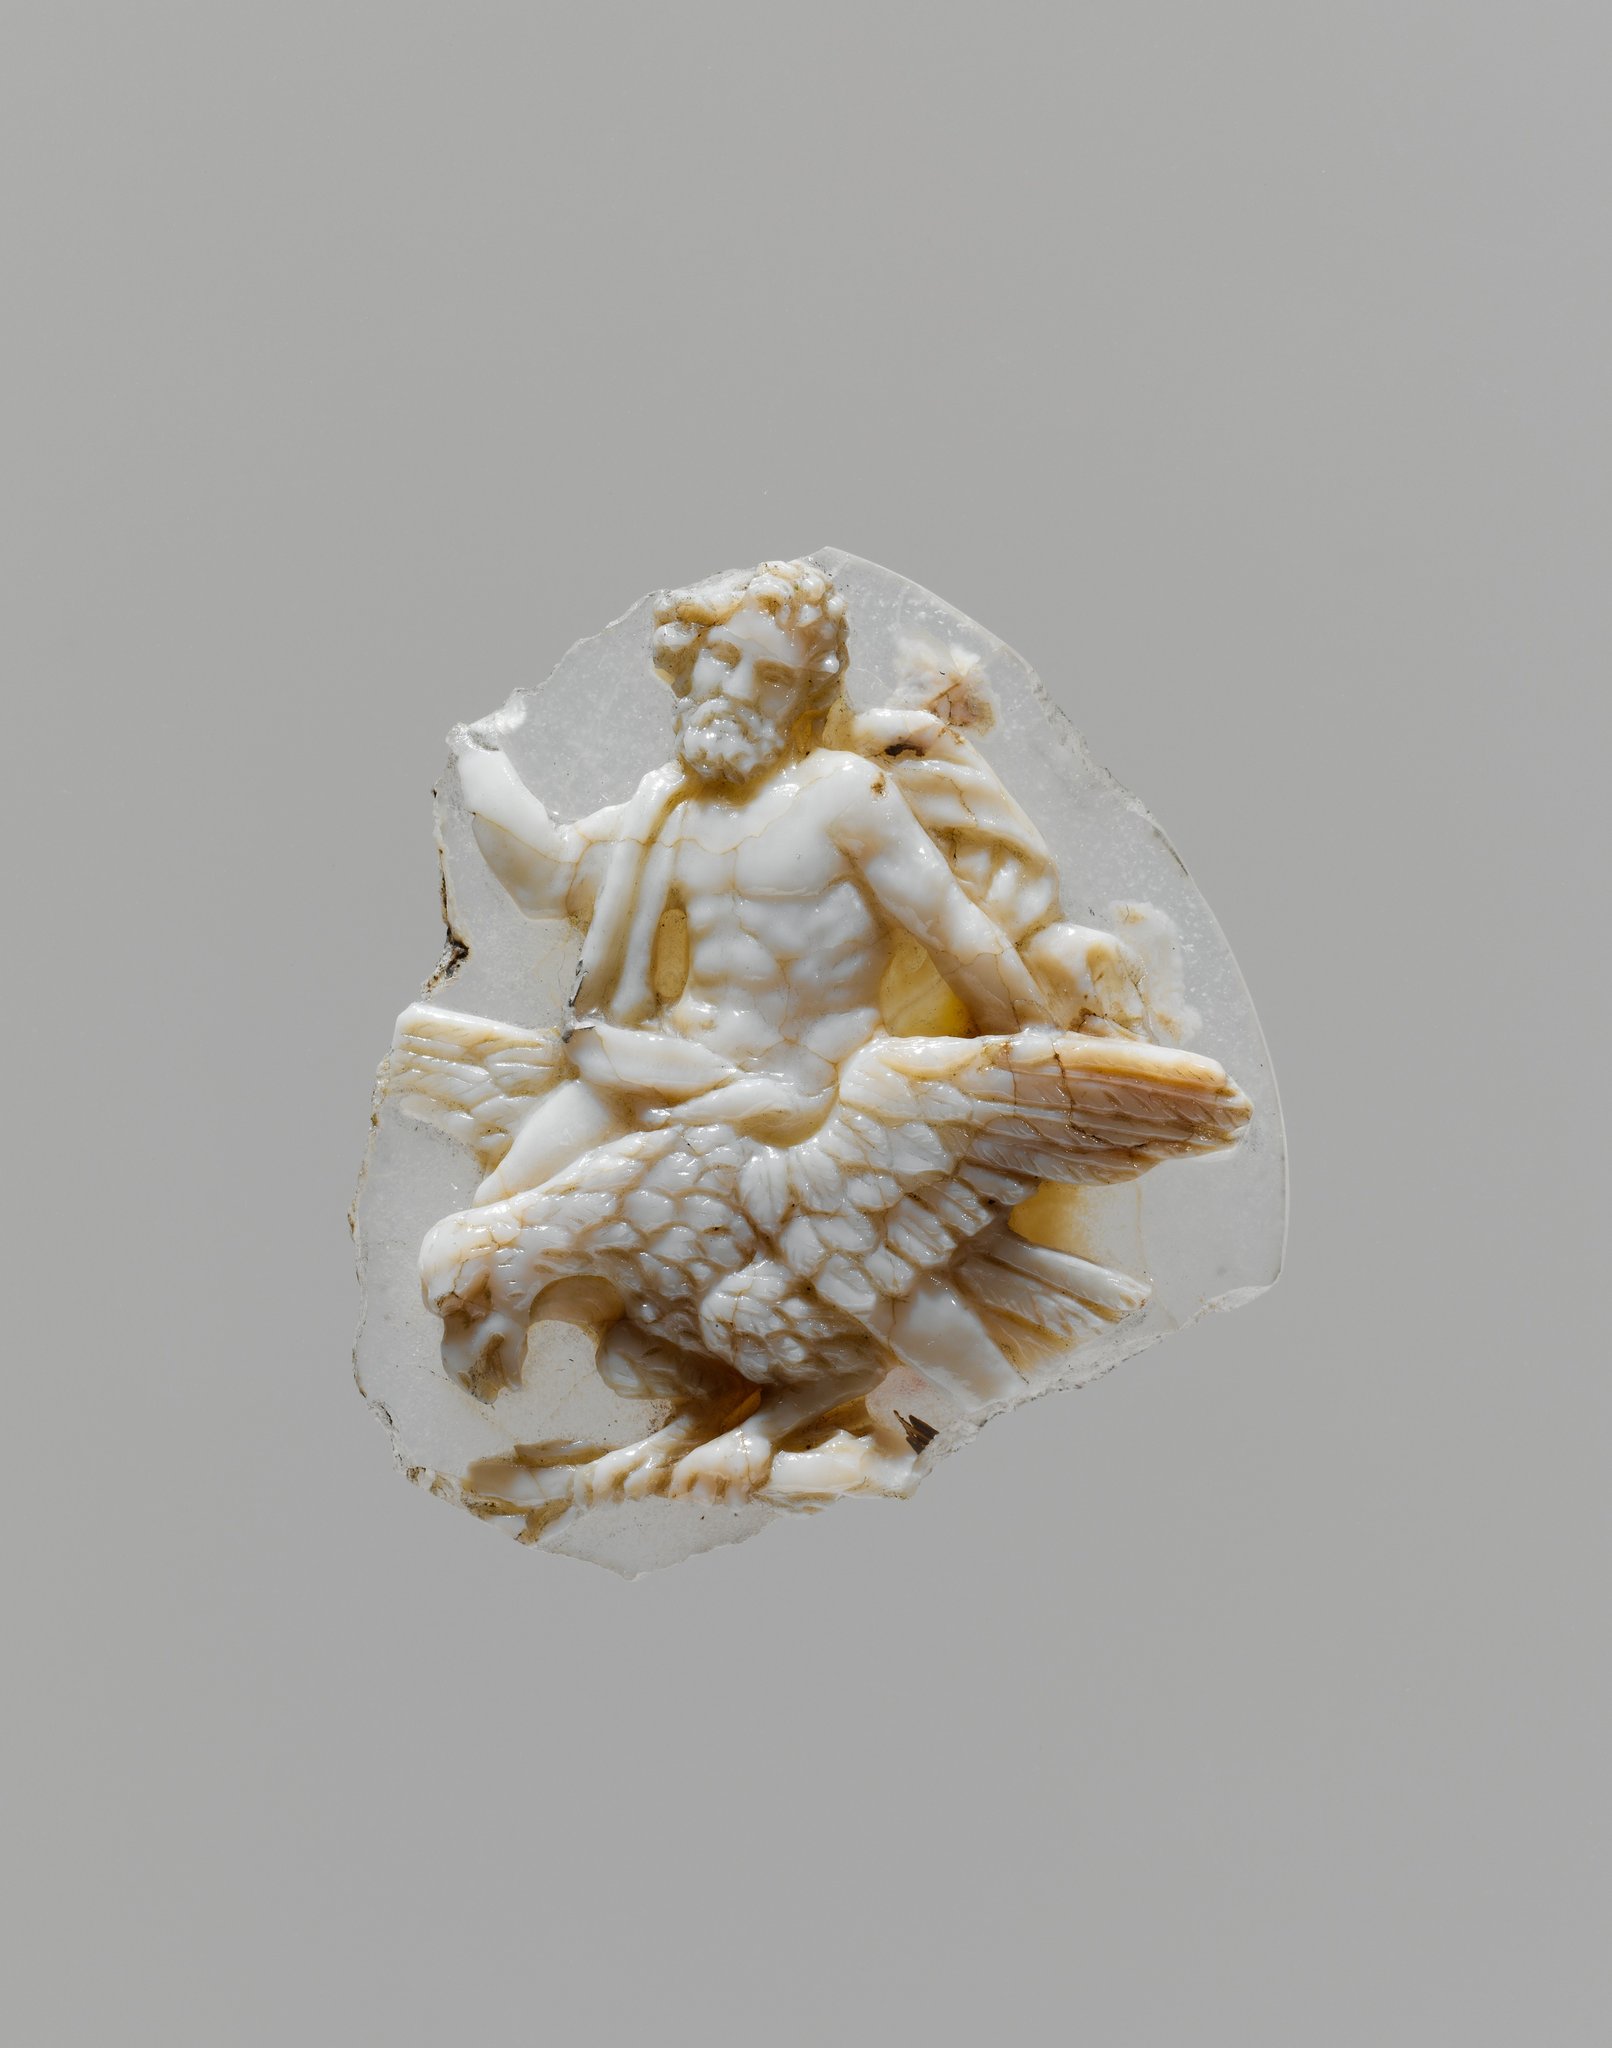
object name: cameo, fragment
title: Sardonyx cameo fragment with Jupiter astride an eagle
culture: greek or roman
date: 100 BCE-100 CE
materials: gemstone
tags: eagles,men,jupiter